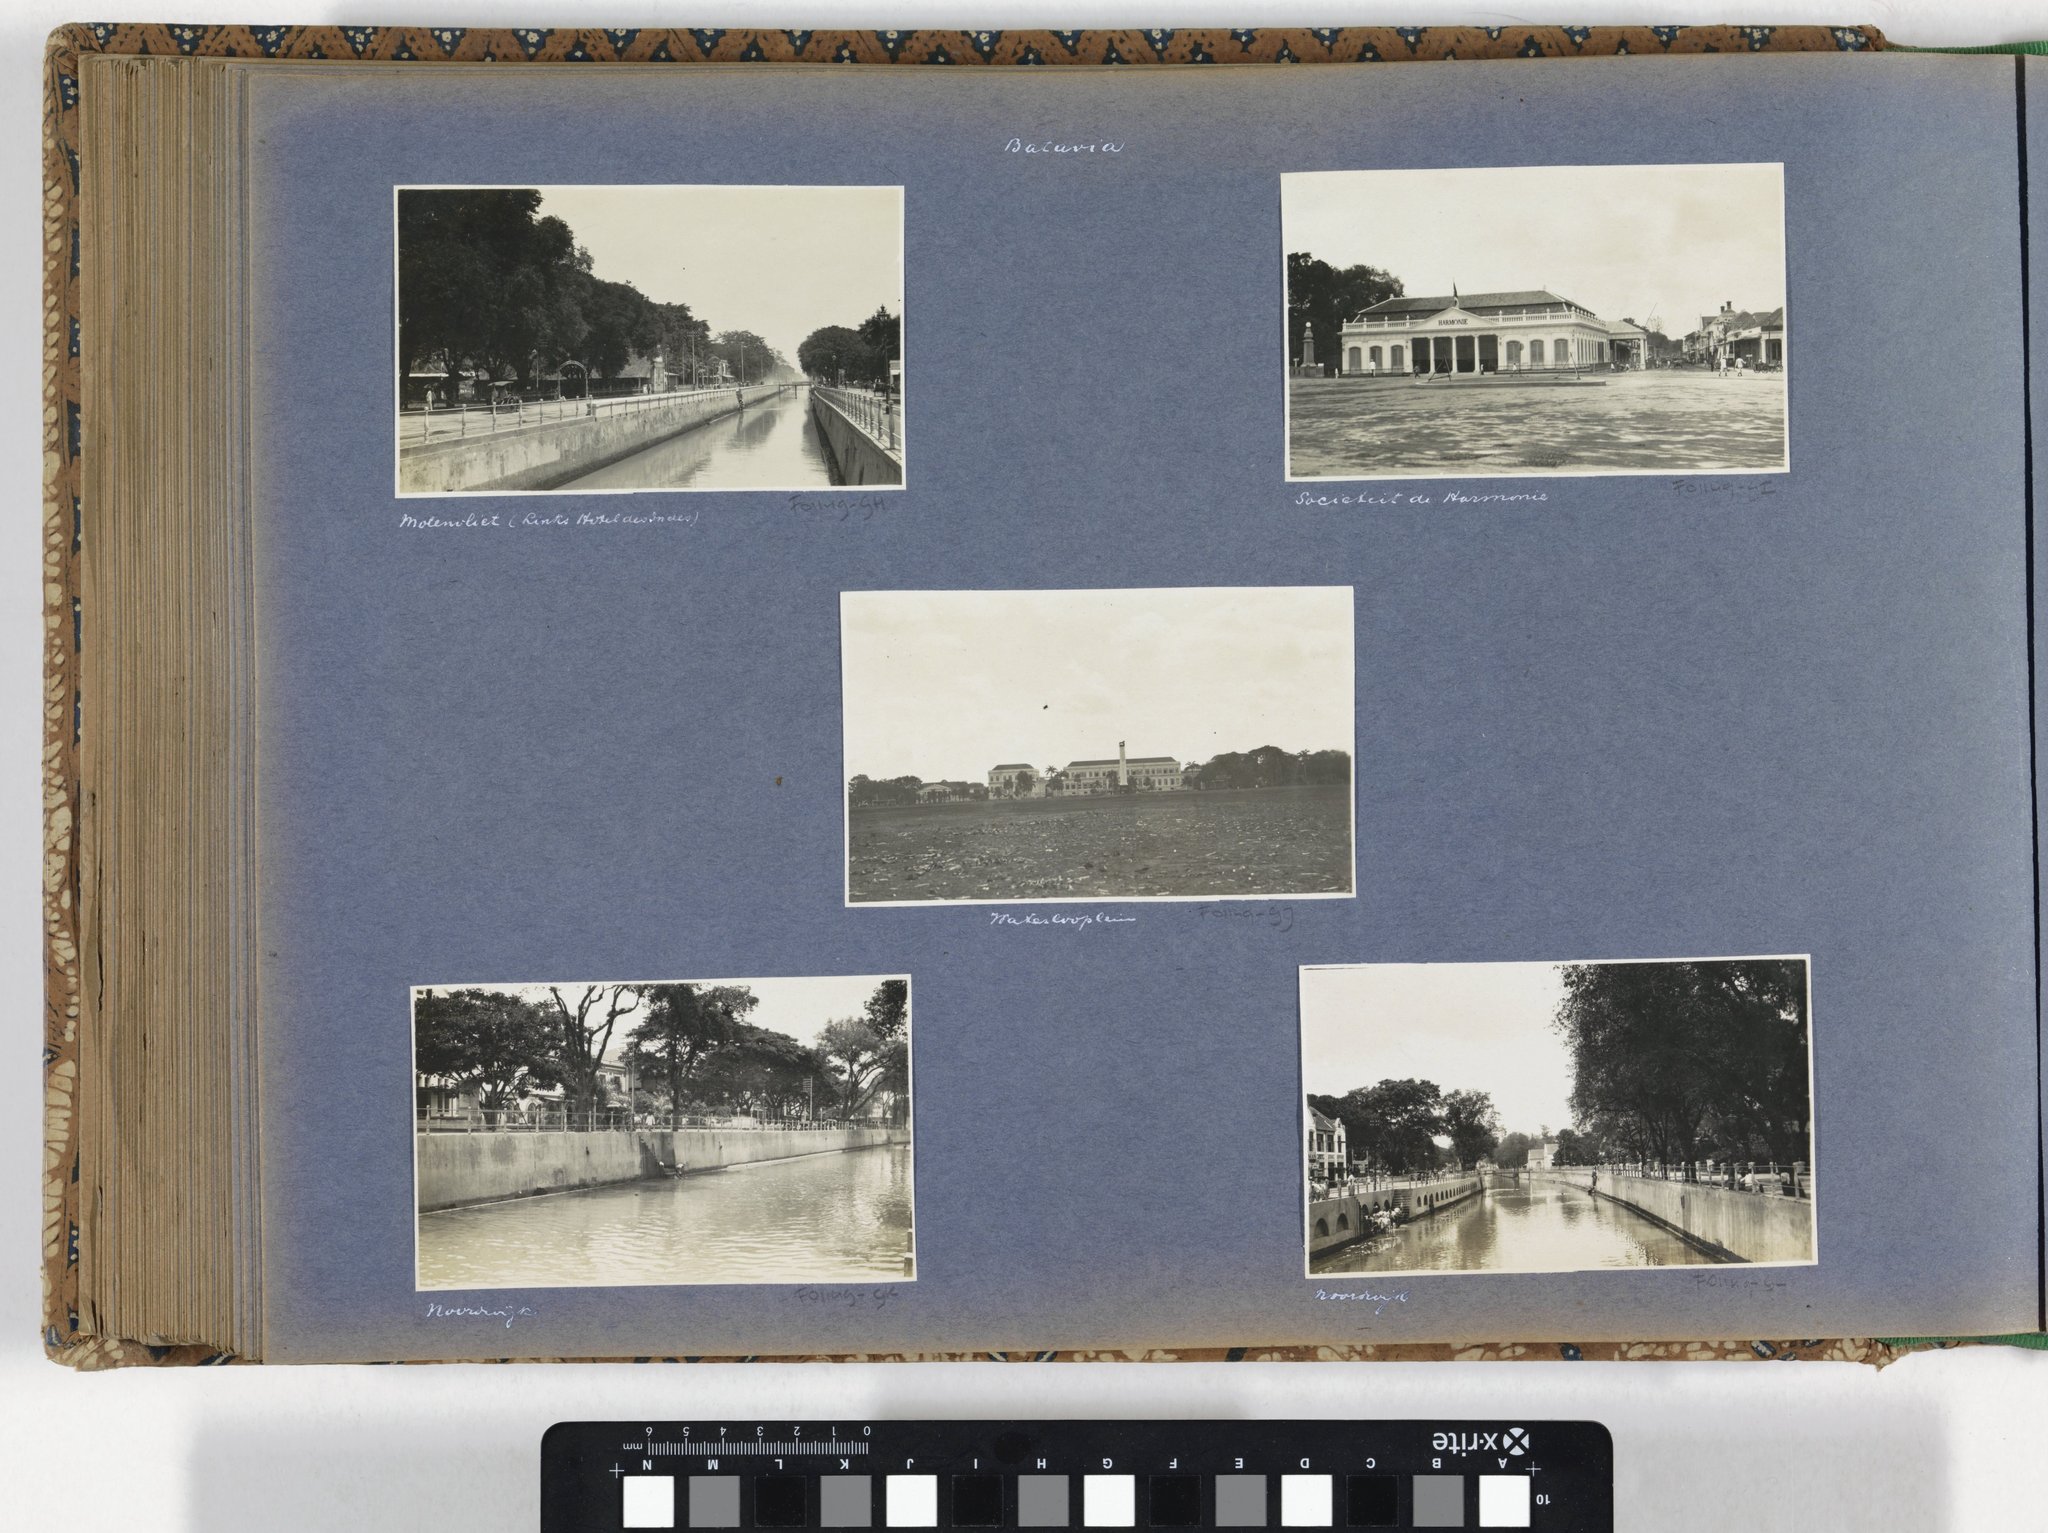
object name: album leaf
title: Gezicht op het Waterlooplein in Batavia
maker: Anonymous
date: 1900-1920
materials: paper, photographic support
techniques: gelatin silver print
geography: batavia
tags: square, place, circus, etc., batavia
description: Onderdeel van reisalbum met foto's van bedrijvigheid en bezienswaardigheden op Sumatra en Java en van de reis naar en van Nederlands-Indië.